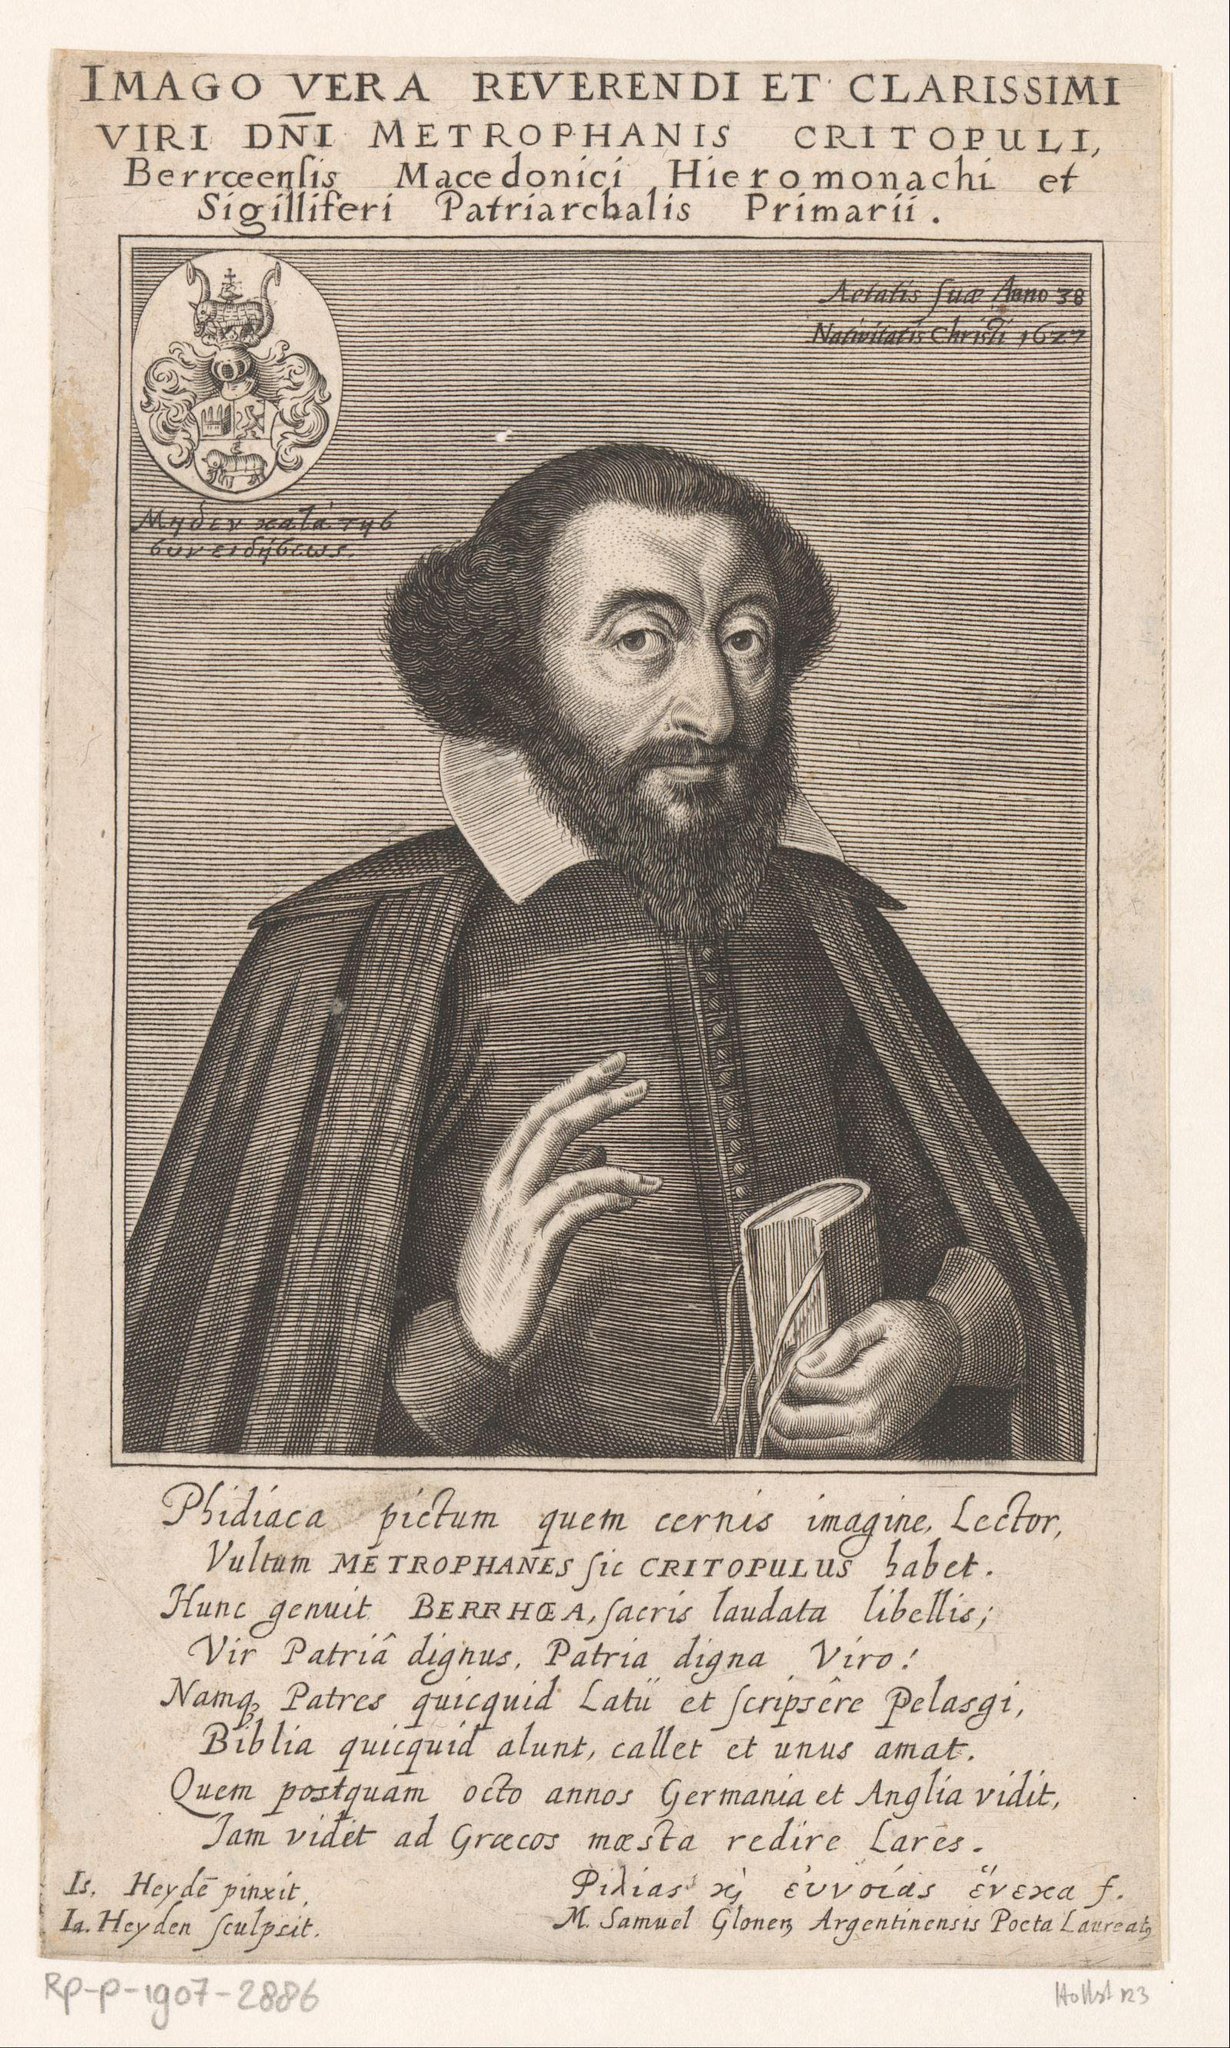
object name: print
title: Portret van Metrophanes Critopoulos op 38-jarige leeftijd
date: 1627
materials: paper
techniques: engraving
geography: straatsburg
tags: historical persons, book, armorial bearing, heraldry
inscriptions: collector's mark: Lugt 2228